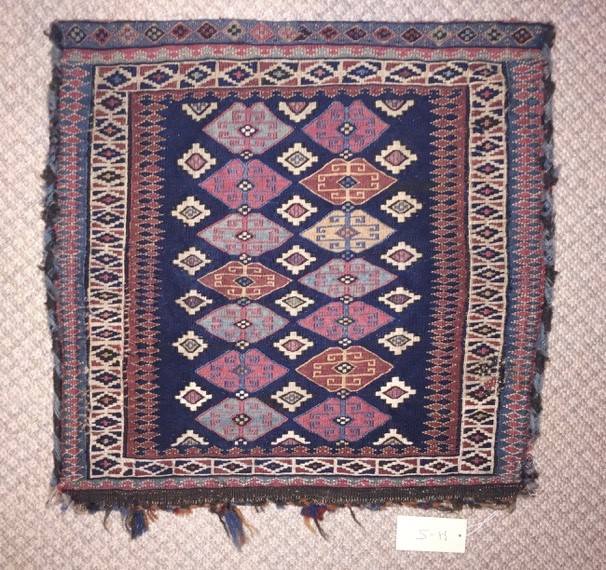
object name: saddle bag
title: Shahsevan Saddle Bag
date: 1850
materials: cotton, wool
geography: iran